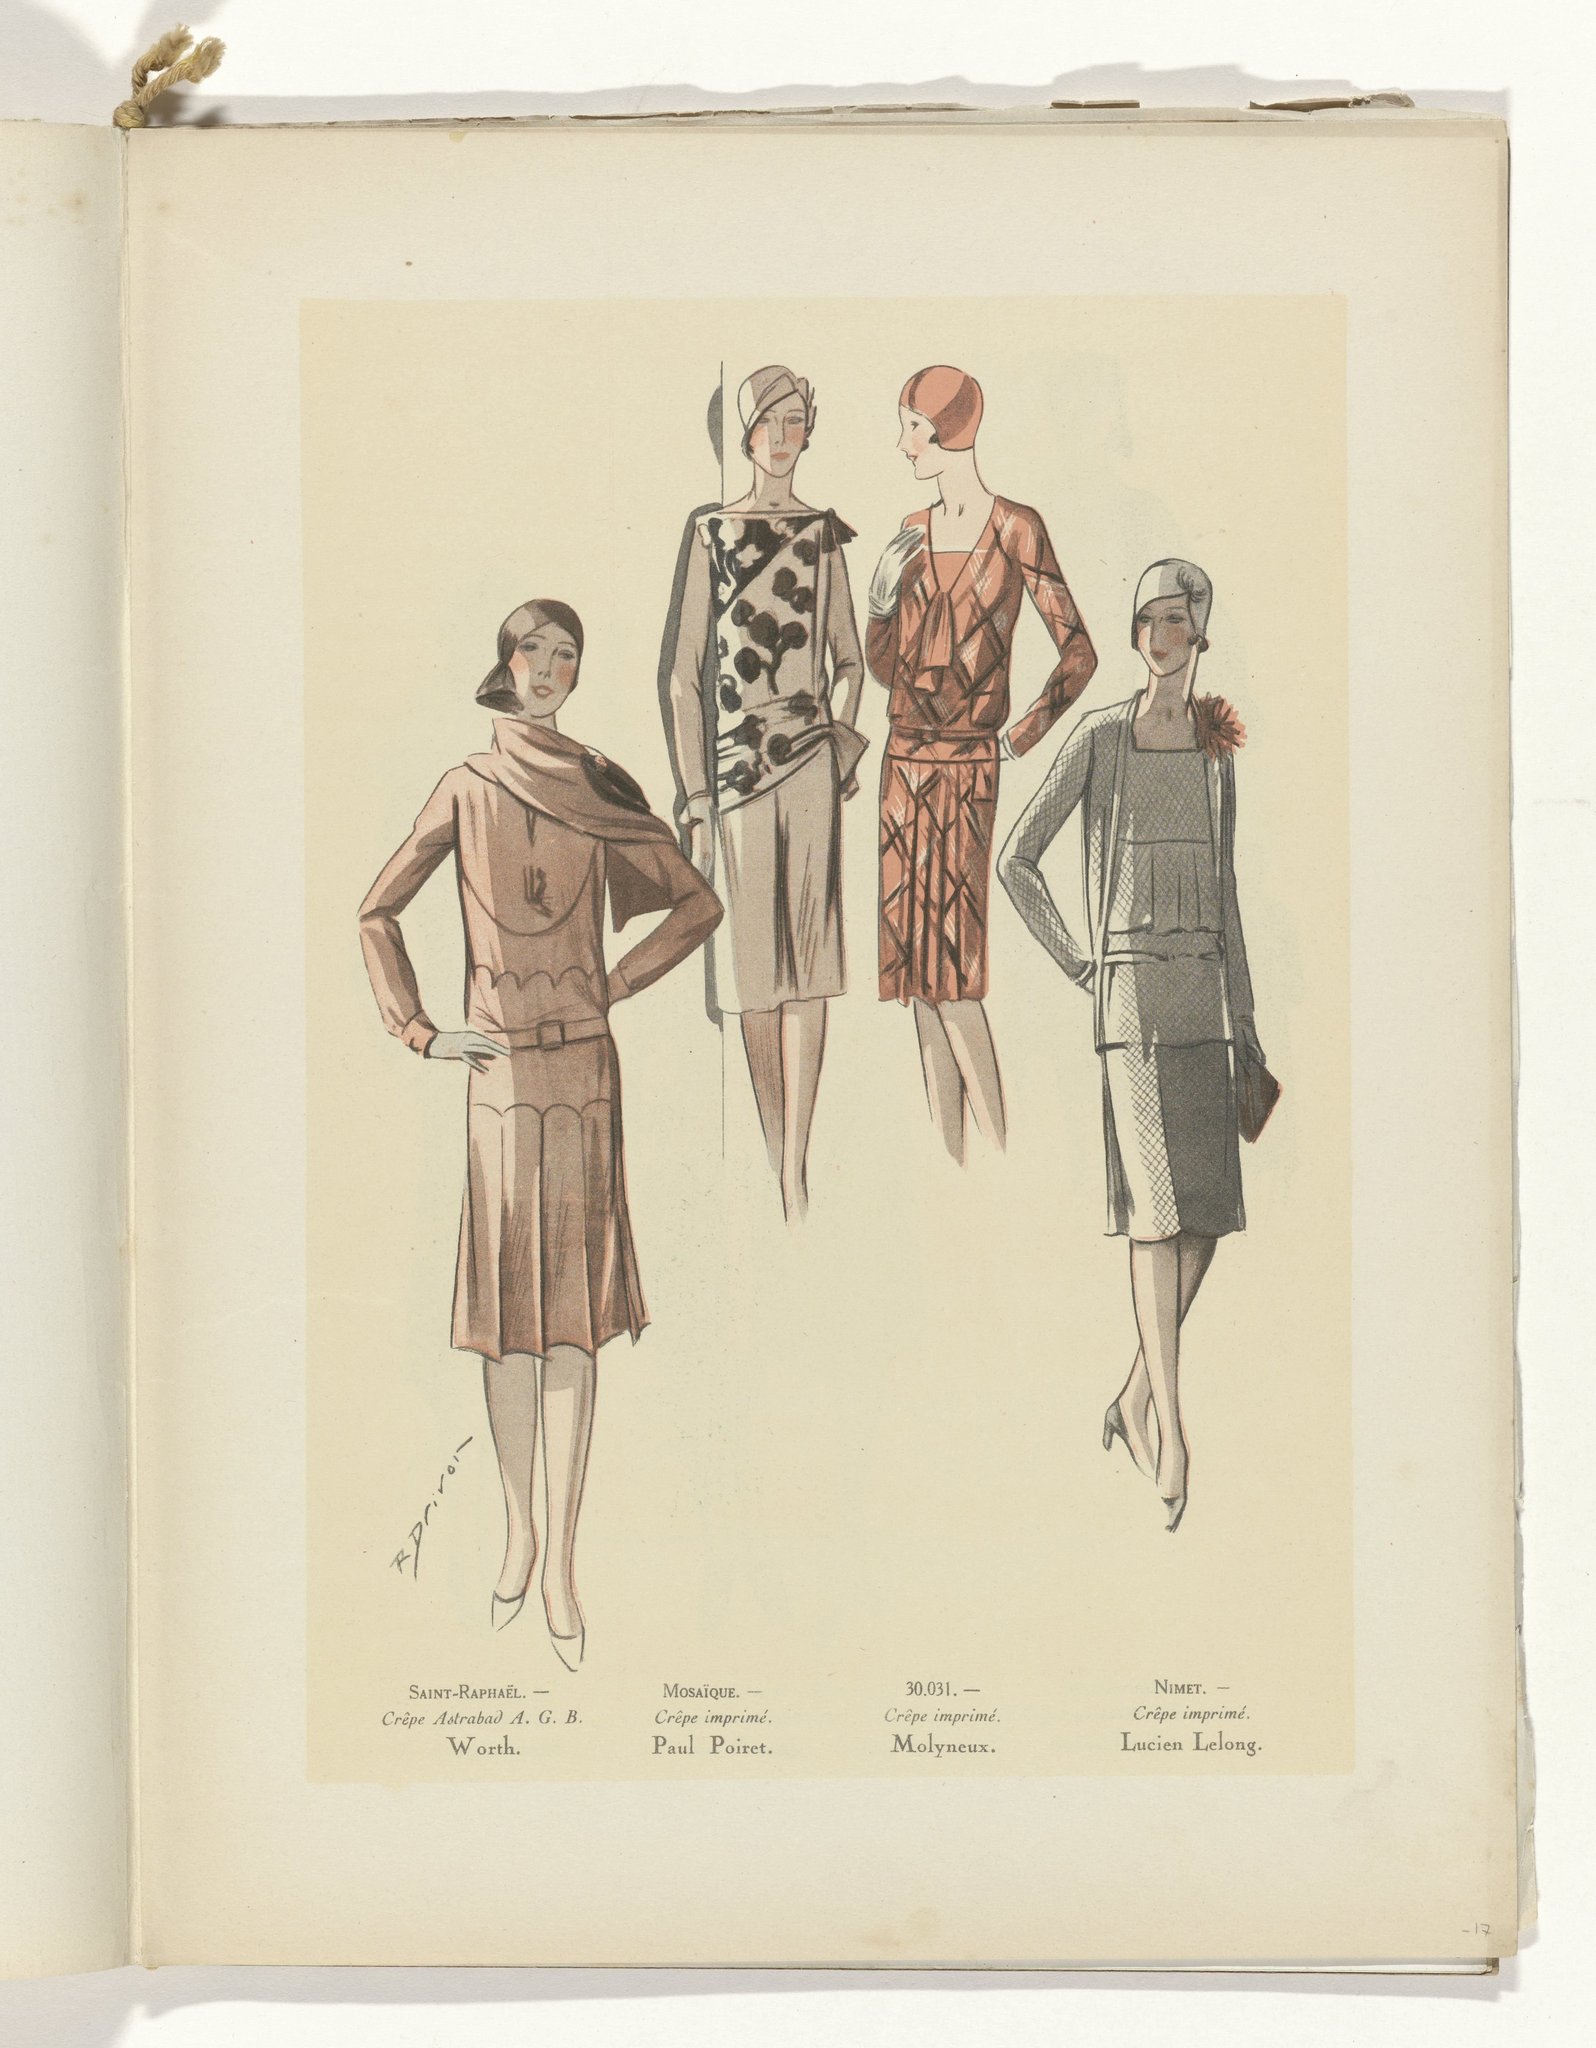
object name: magazine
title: Art - Goût - Beauté, Feuillets de l' élégance féminine, Mars 1929, No. 103, 9e Année, p. 17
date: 1929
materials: paper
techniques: printing, photography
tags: dress, gown: day dress (+ women's clothes), fashion plates, dress, gown (+ women's clothes)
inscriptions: caption: ‘SAINT-RAPHAËL. - Crêpe Astrabad A.G.B. Worth. / MOSAÏQUE. - Crêpe imprimé. Paul Poiret / 30.031. - Crêpe imprimé. Molyneux / NIMET. - Crêpe imprimé. Lucien Lelong’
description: Japonnen van Worth, Paul Poiret, Molyneux en Lucien Lelong. Pagina uit het modetijdschrift Art-Goût-Beauté (1920-1933).